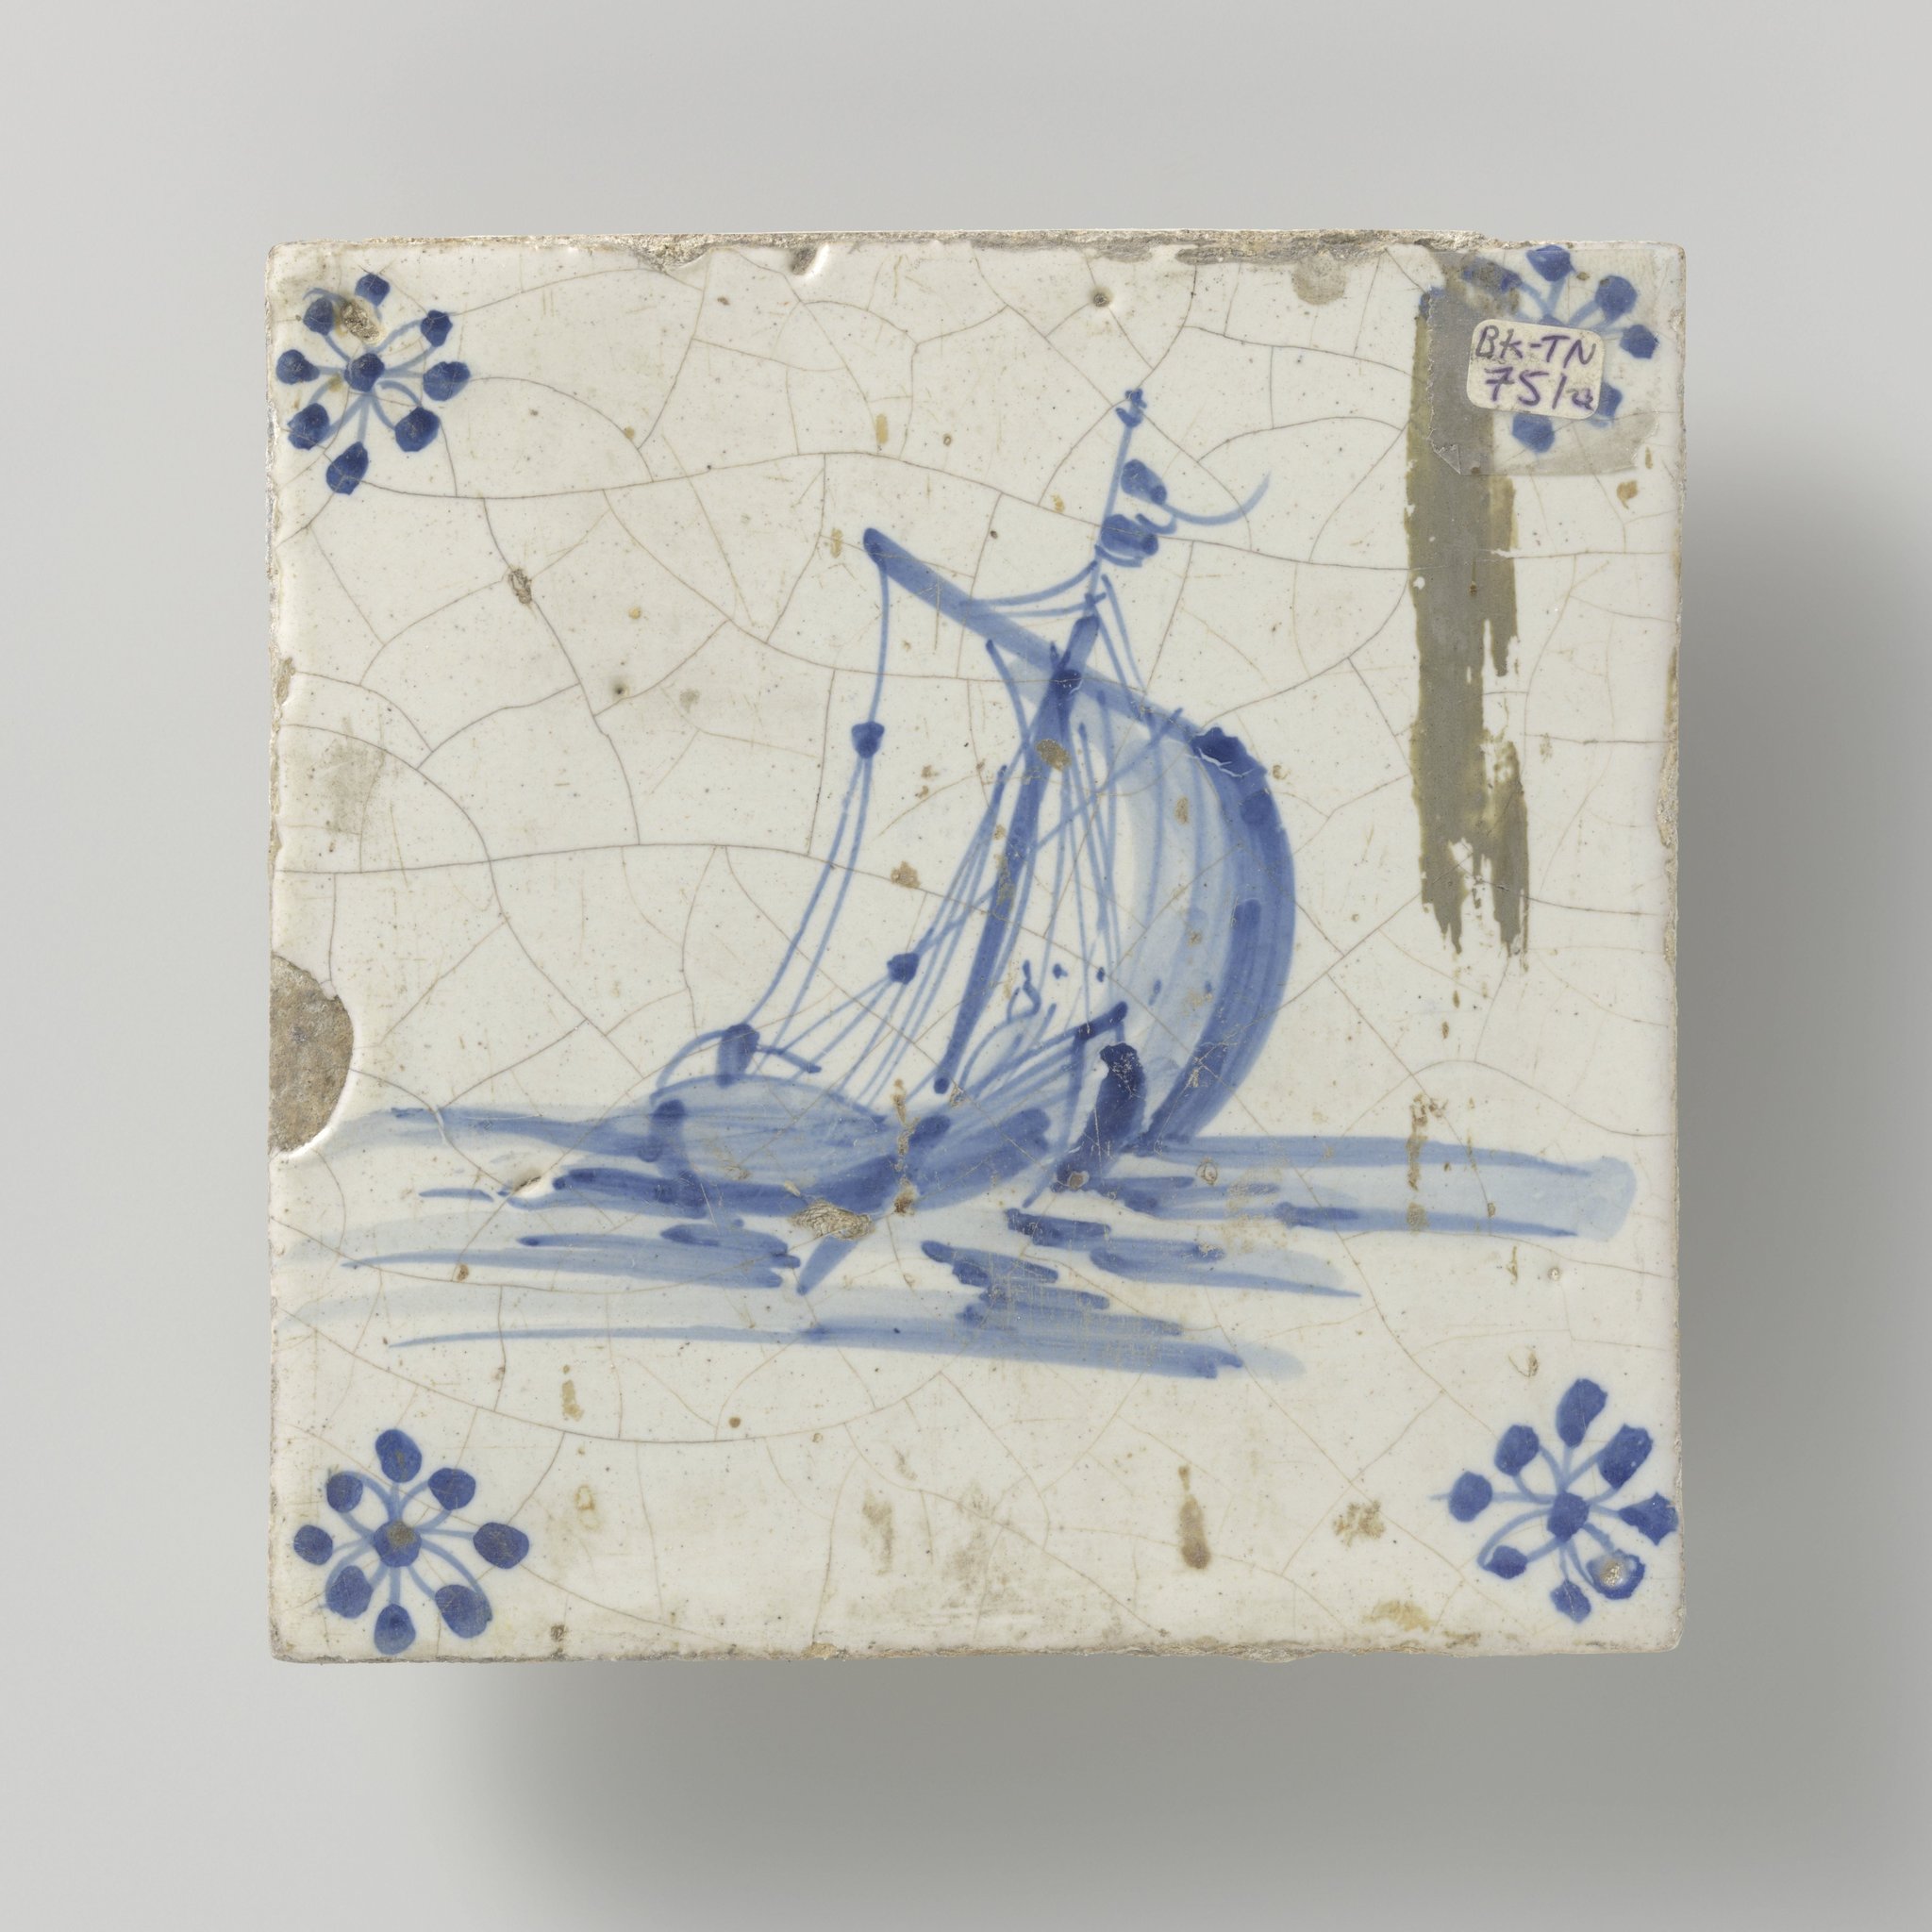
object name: tile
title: Tegel, blauw beschilderd met een schip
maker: Anonymous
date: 1650-1680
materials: earthenware, glaze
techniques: maiolica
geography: netherlands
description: Tegel, blauw beschilderd met een schip, zogenaamd boerenscheepje. In de hoeken een spinnekop.